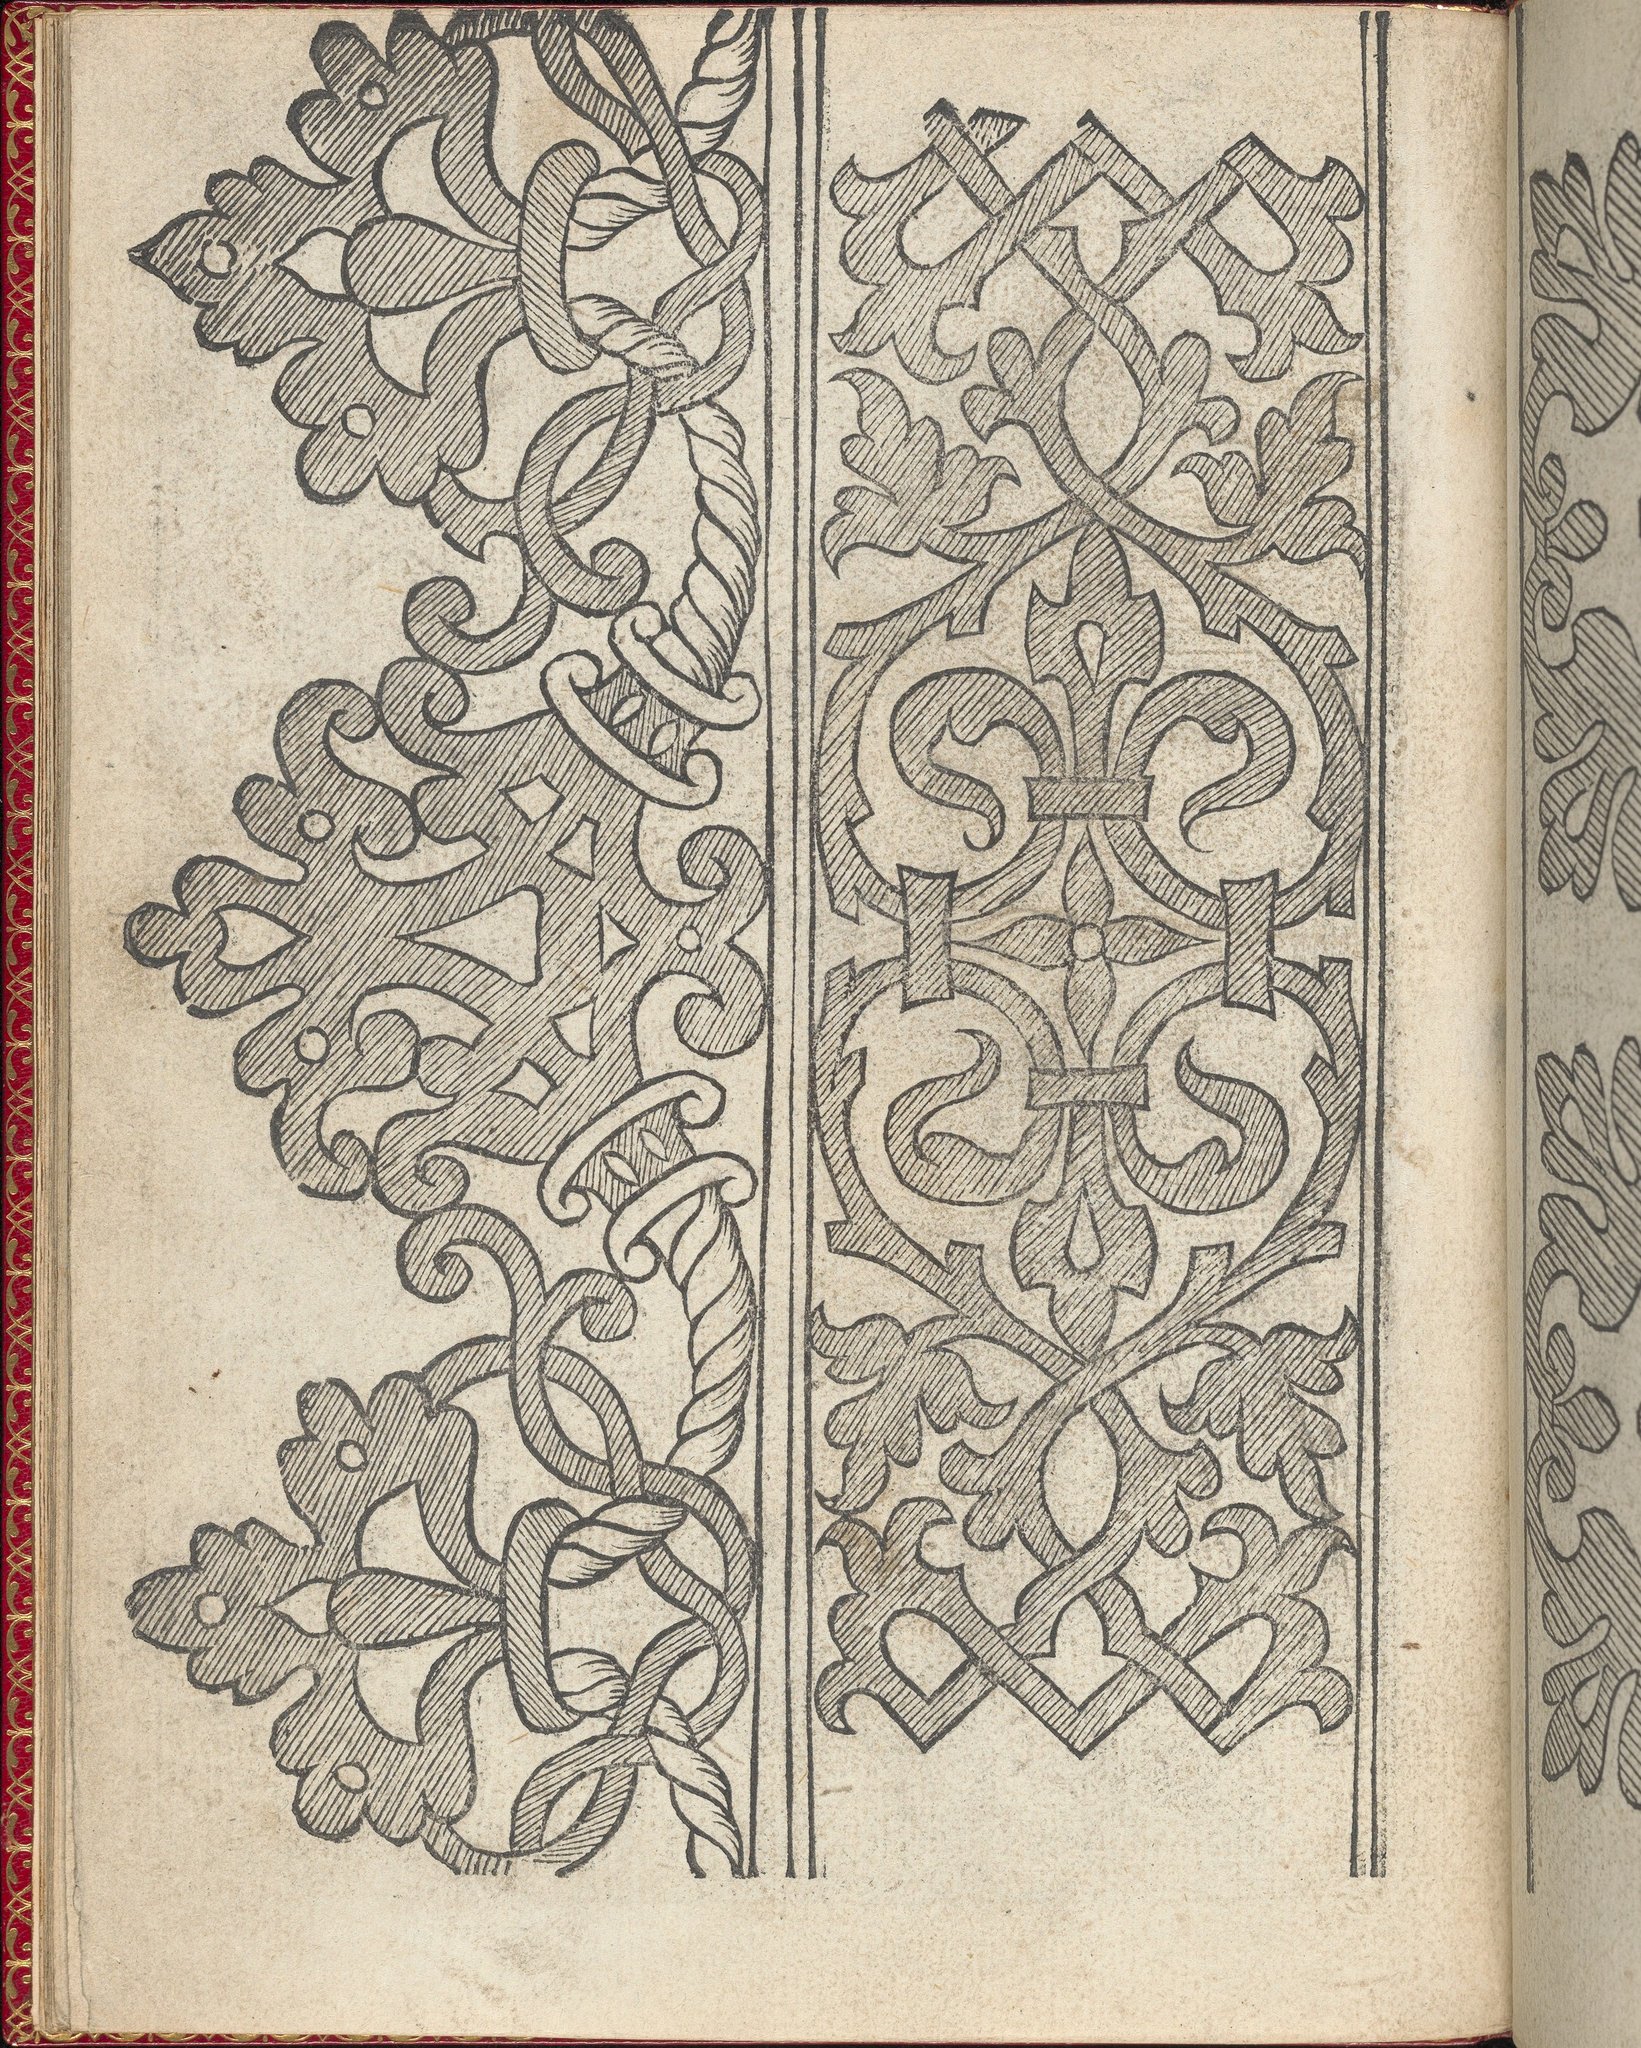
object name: book print ornament architecture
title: Il Monte. Opera Nova di Recami, page 9 (verso)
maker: giovanni antonio bindoni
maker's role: designer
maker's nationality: italian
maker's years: 1500-1650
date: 1557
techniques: woodcut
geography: italy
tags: cornucopia,flowers